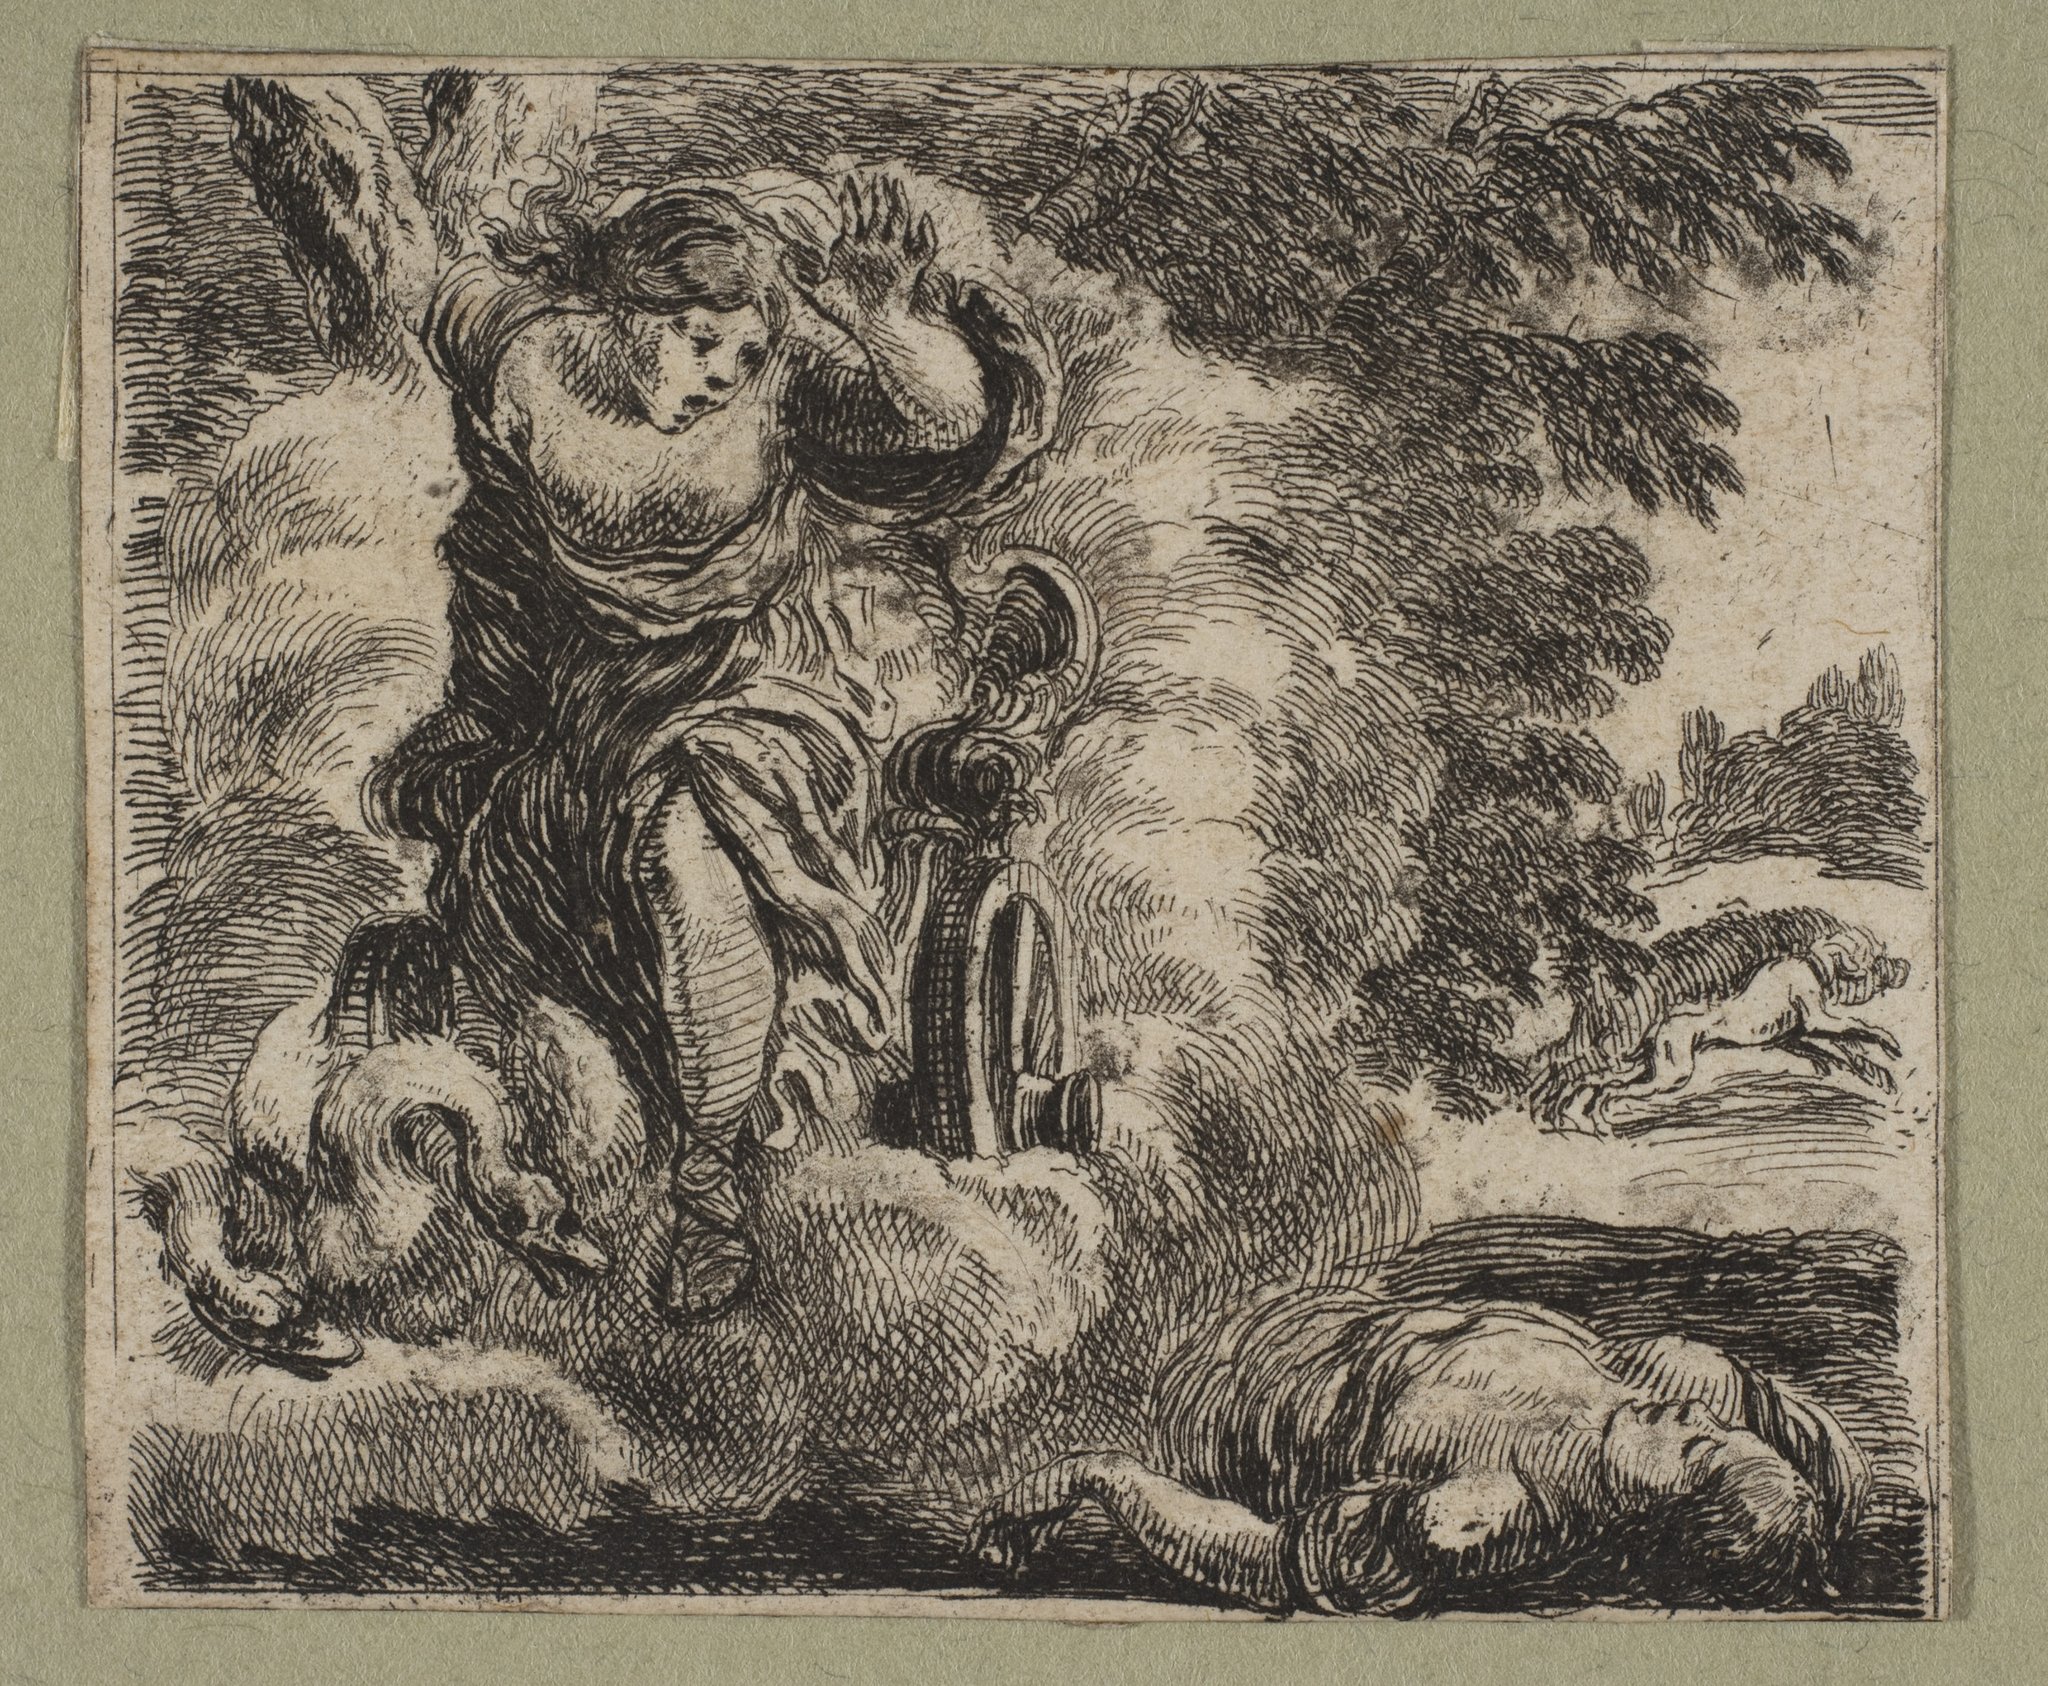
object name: print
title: Venus et Adonis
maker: stefano della bella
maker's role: artist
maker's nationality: italian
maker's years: 1610-1664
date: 1644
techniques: etching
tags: adonis,venus,serpents